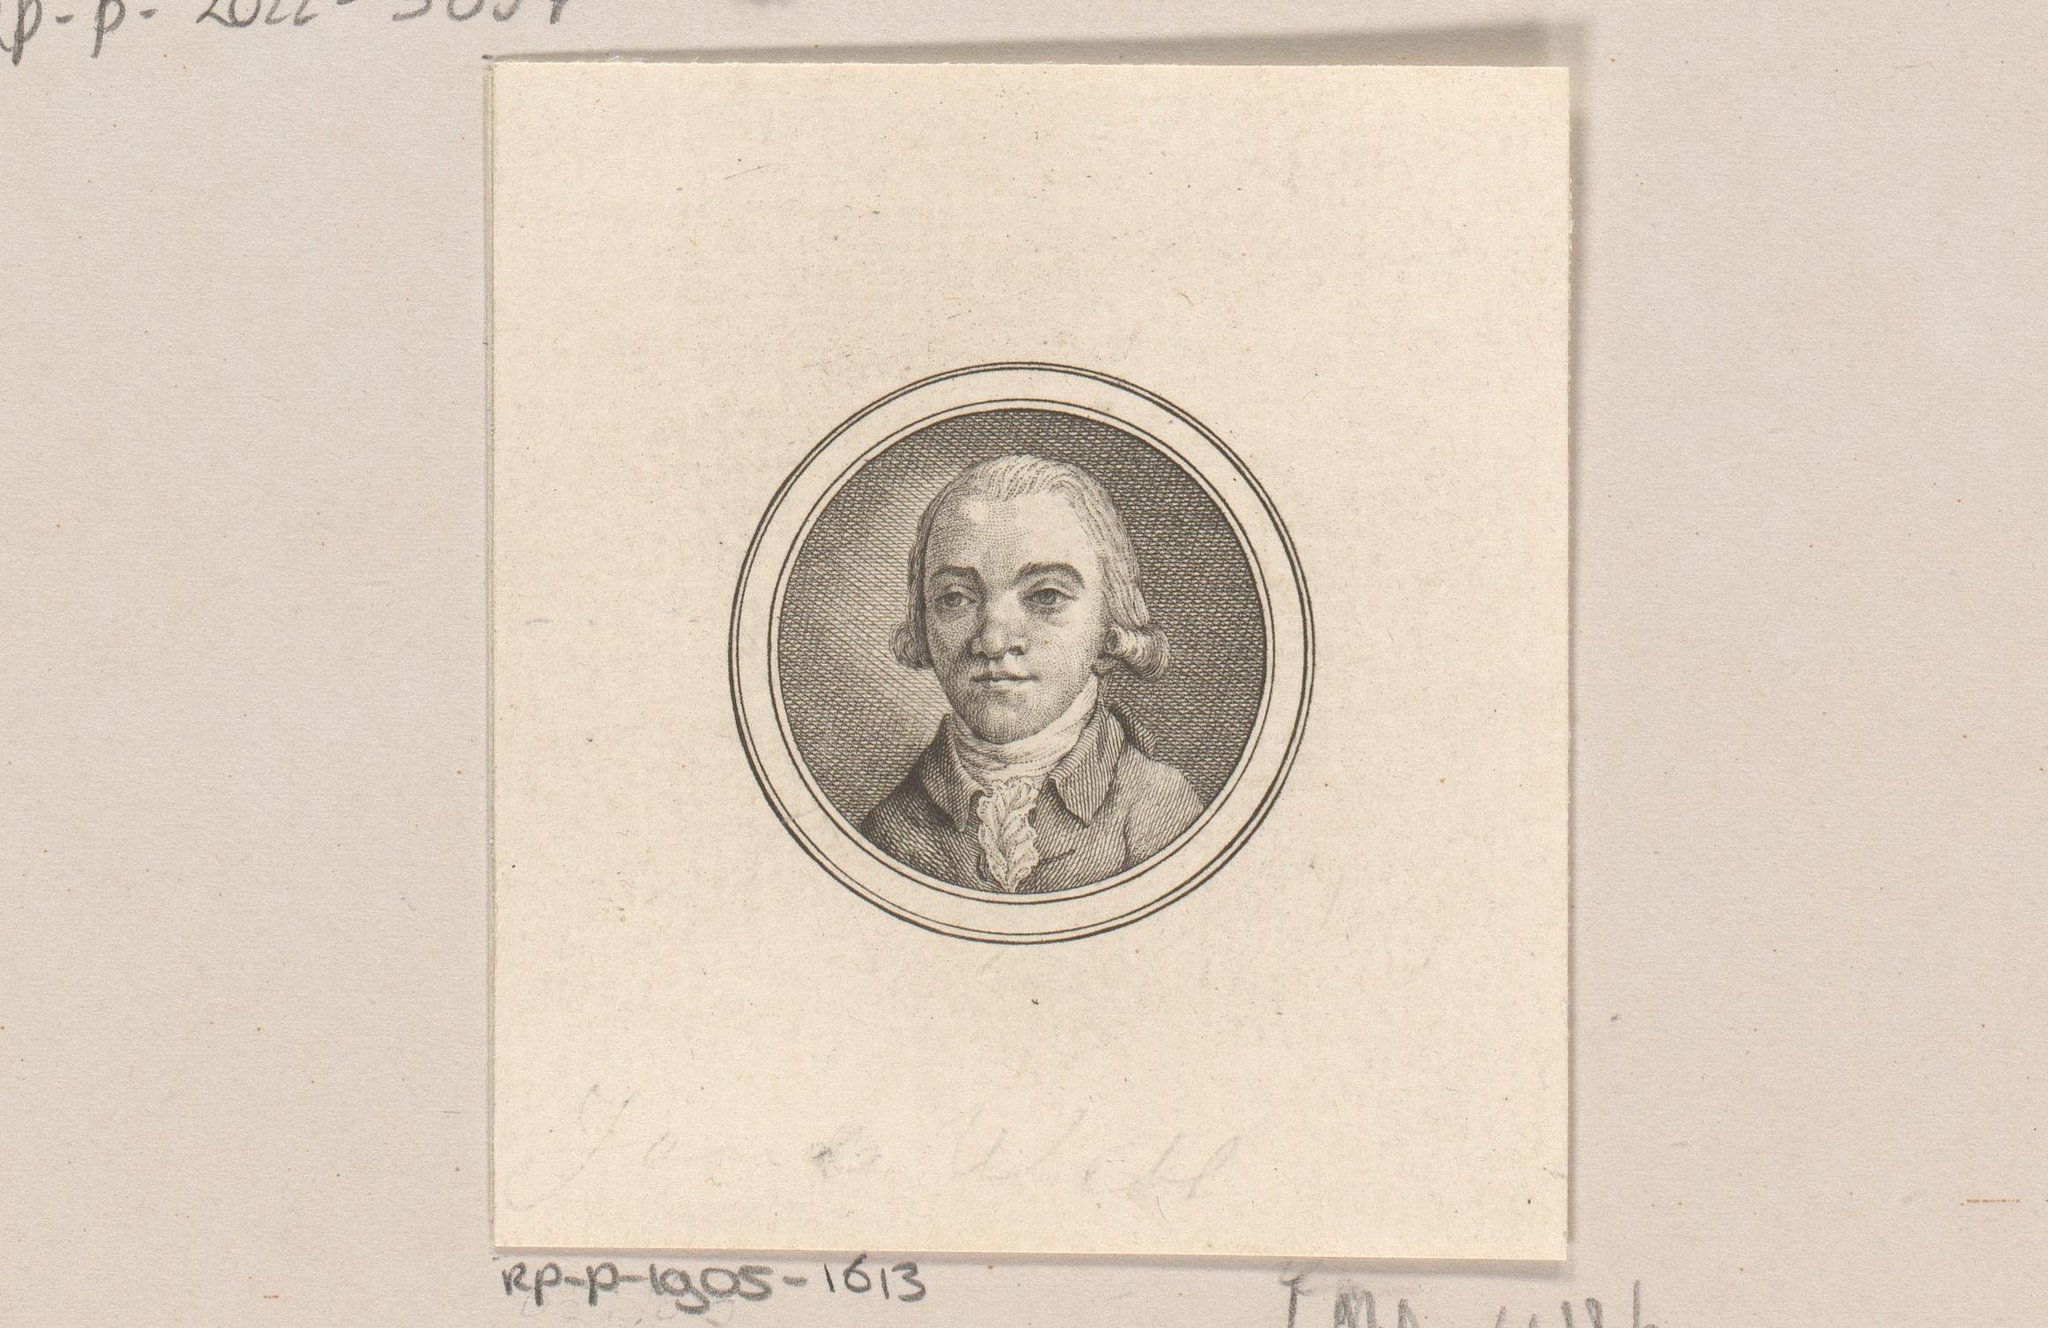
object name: print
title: Portret van Jan de Witt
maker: abraham jacobsz. hulk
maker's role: print maker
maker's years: 1751-1817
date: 1787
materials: paper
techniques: etching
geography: paris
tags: france, historical persons, municipal government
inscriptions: collector's mark: Lugt 2228